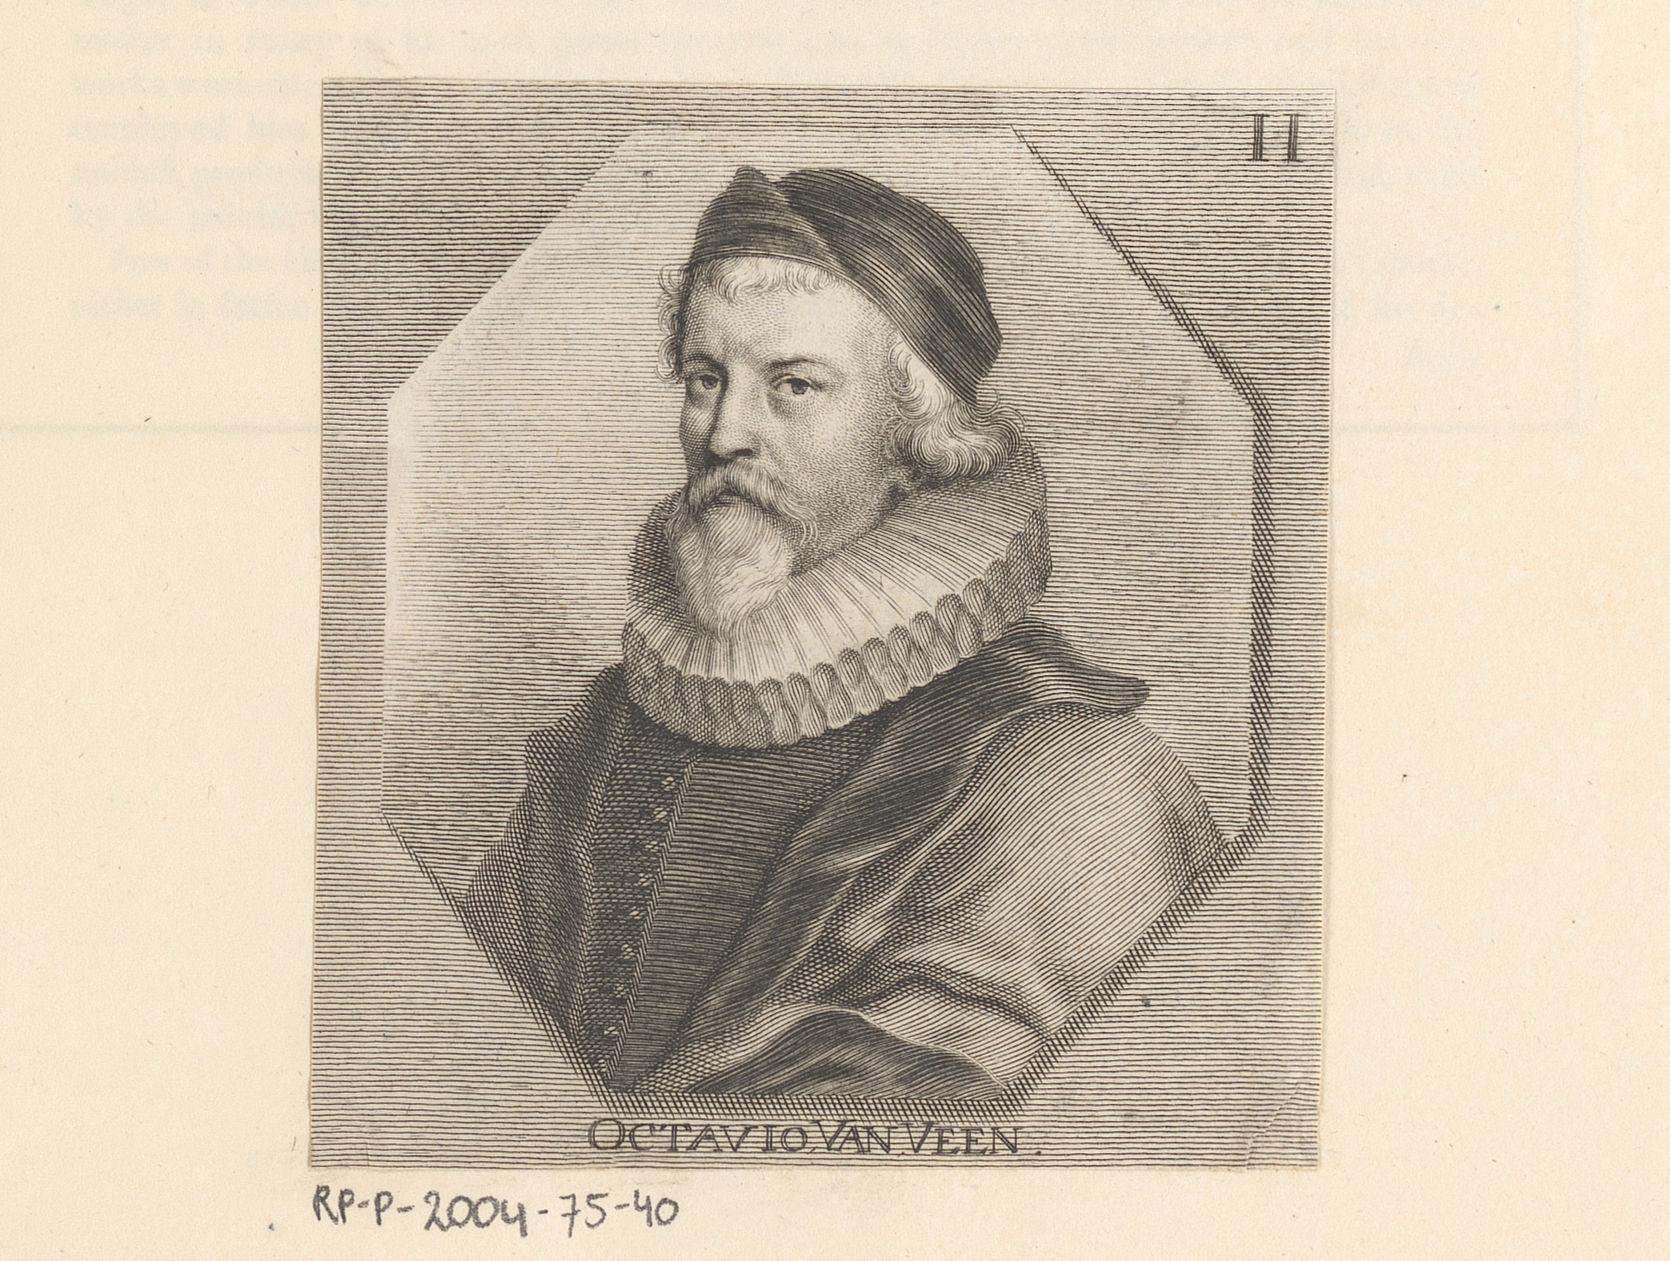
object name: album leaf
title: Octavio van Veen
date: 1675-1679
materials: paper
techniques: engraving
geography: nuremberg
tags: leiden, brussels, painter, draughtsman, otto van veen, historical persons, portrait, self-portrait of painter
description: Prent uit: Sandrart, Joachim von. Teutsche Academie der Edlen Bau- Bild- und Mahlerey-Künste (...). Neurenberg: Jakob von Sandrart, [1675-1679], dl. 1, p. 292, afb. KK. Latere staat van de prent gebruikt in: Sandrart, Joachim von. Teutsche Academie der Bau- Bildhauer- und Maler-Kunst: worinn die Regeln und Lehrsätze dieser Künste gegeben. 14 dln. Neurenberg: erven Johann Andreas Endter, [1774], dl. 7, p. EE. De samensteller heeft deze prent in het album geplakt als illustratie bij: Pilkington, Matthew en Johann Heinrich Füssli. A dictionary of painters, from the revival of the art to the present period. 4 dln. Londen: John Crowder, 1805, dl. 4, p. 607.